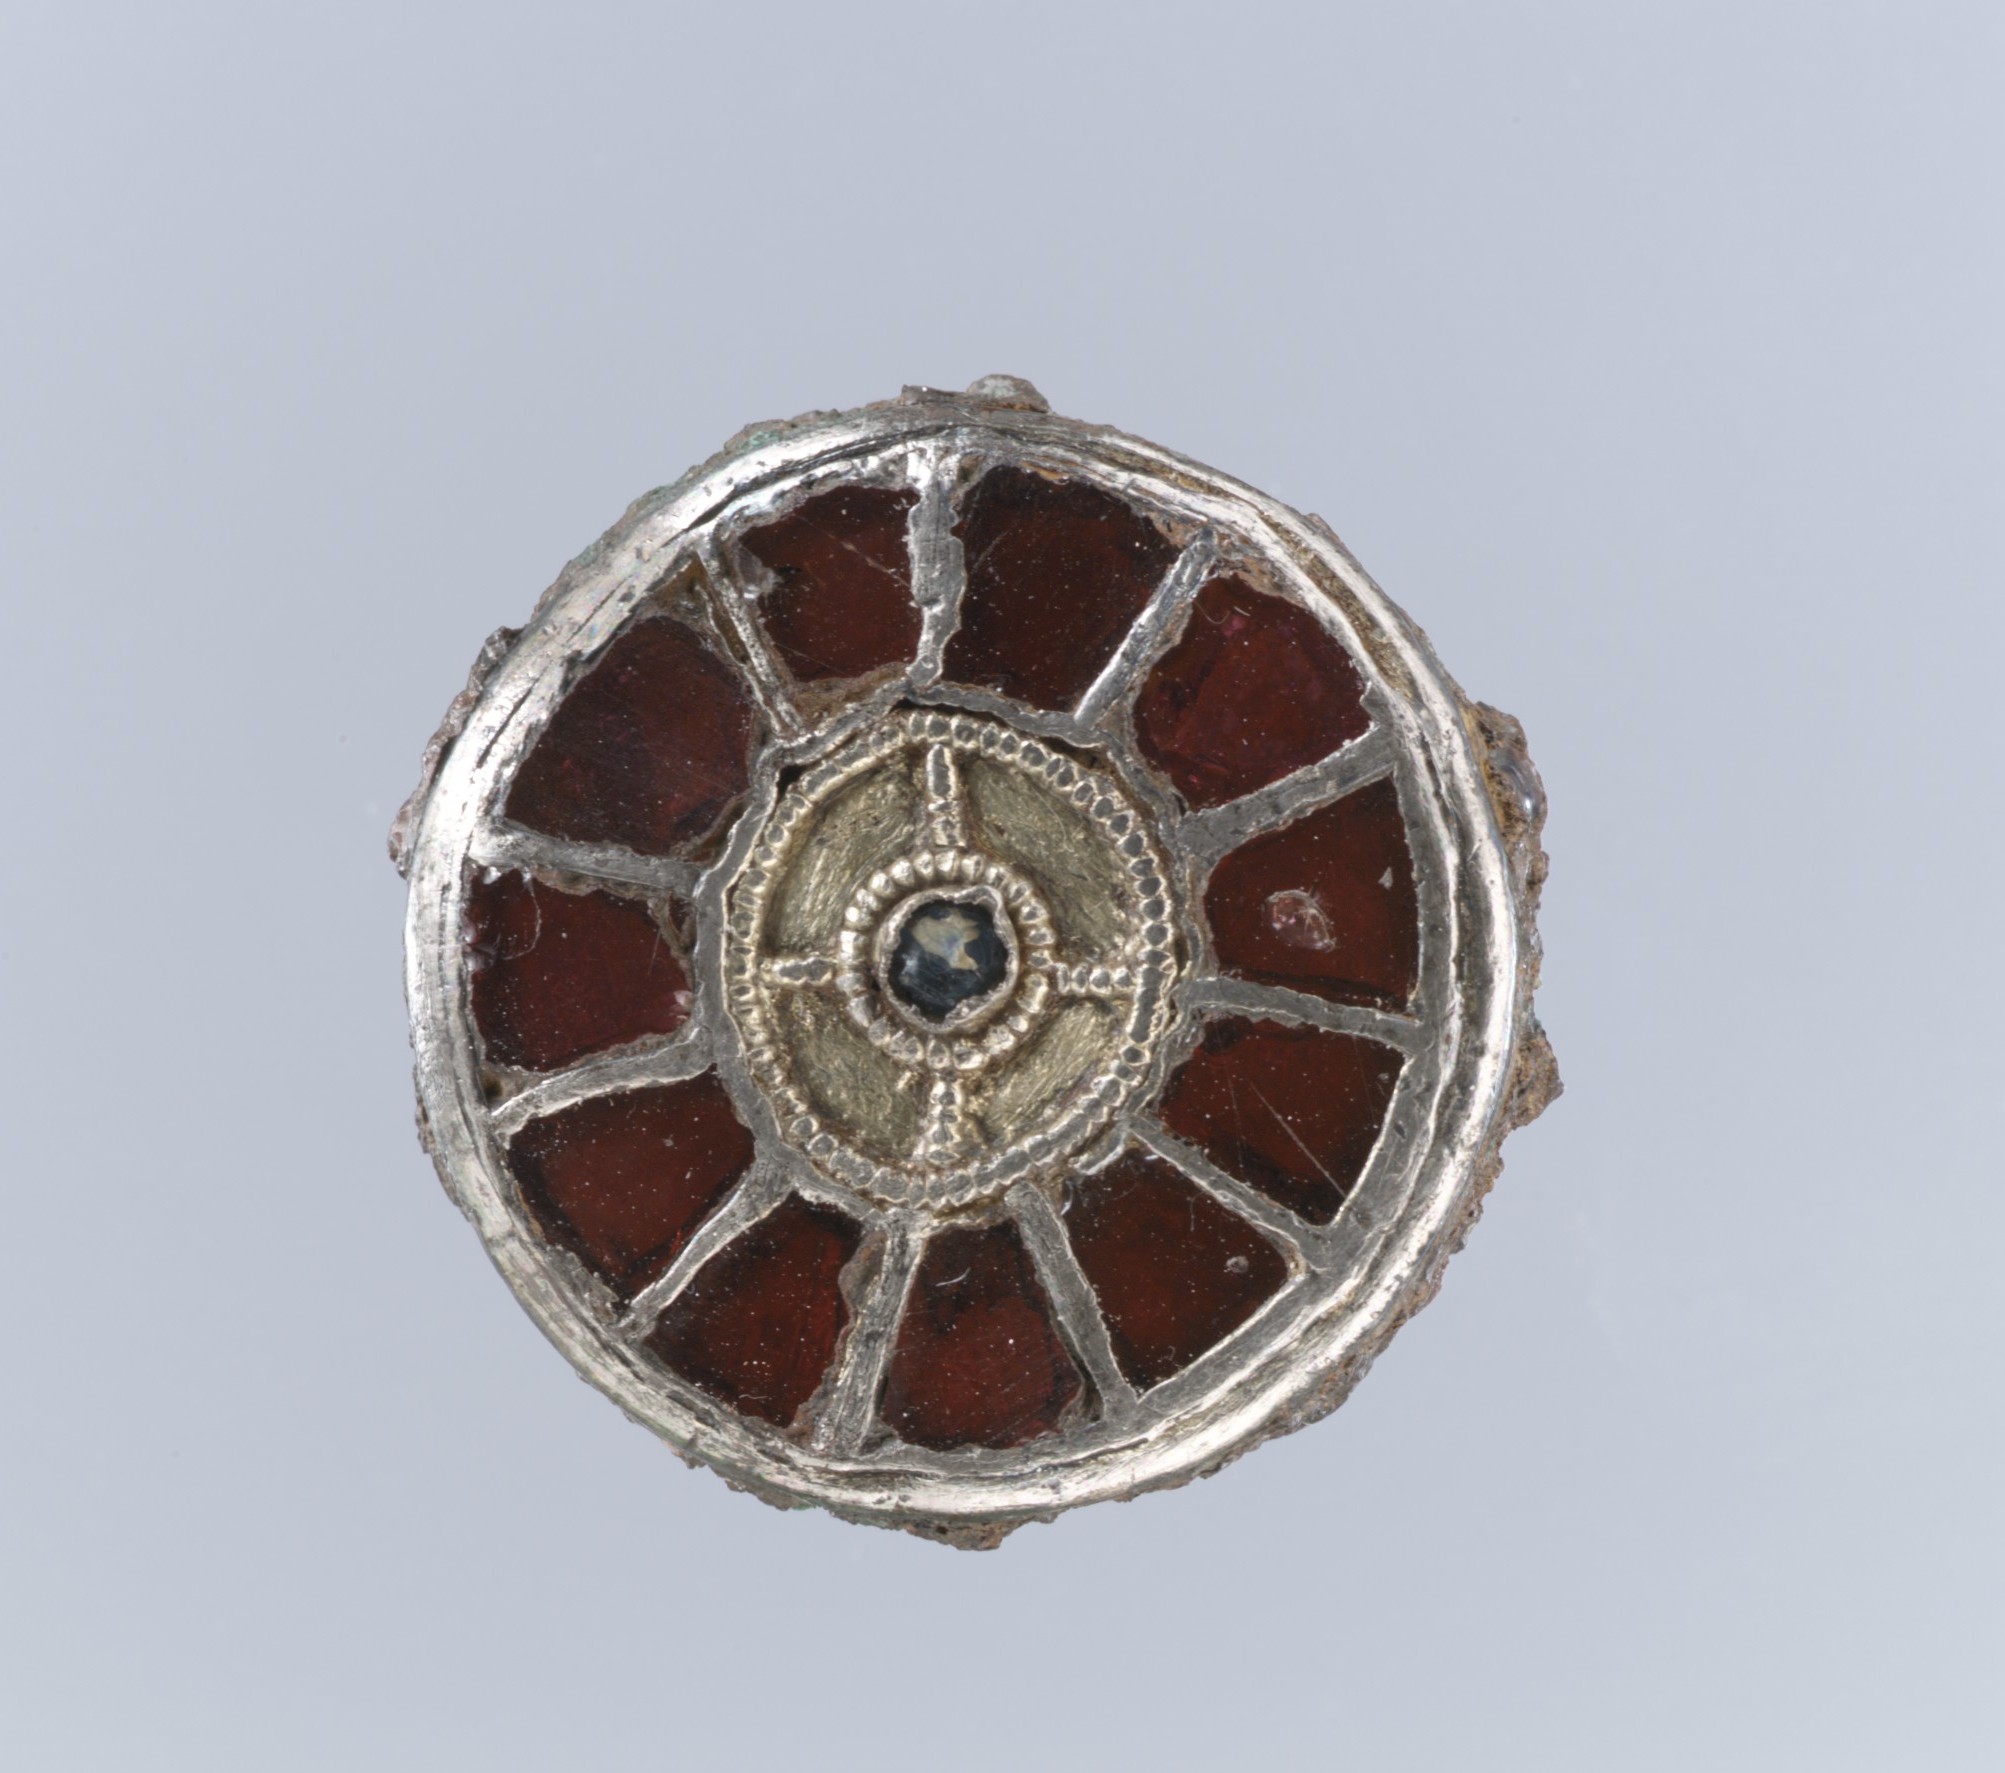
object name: brooch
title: Disk Brooch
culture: frankish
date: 501-600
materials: garnet, glass, silver